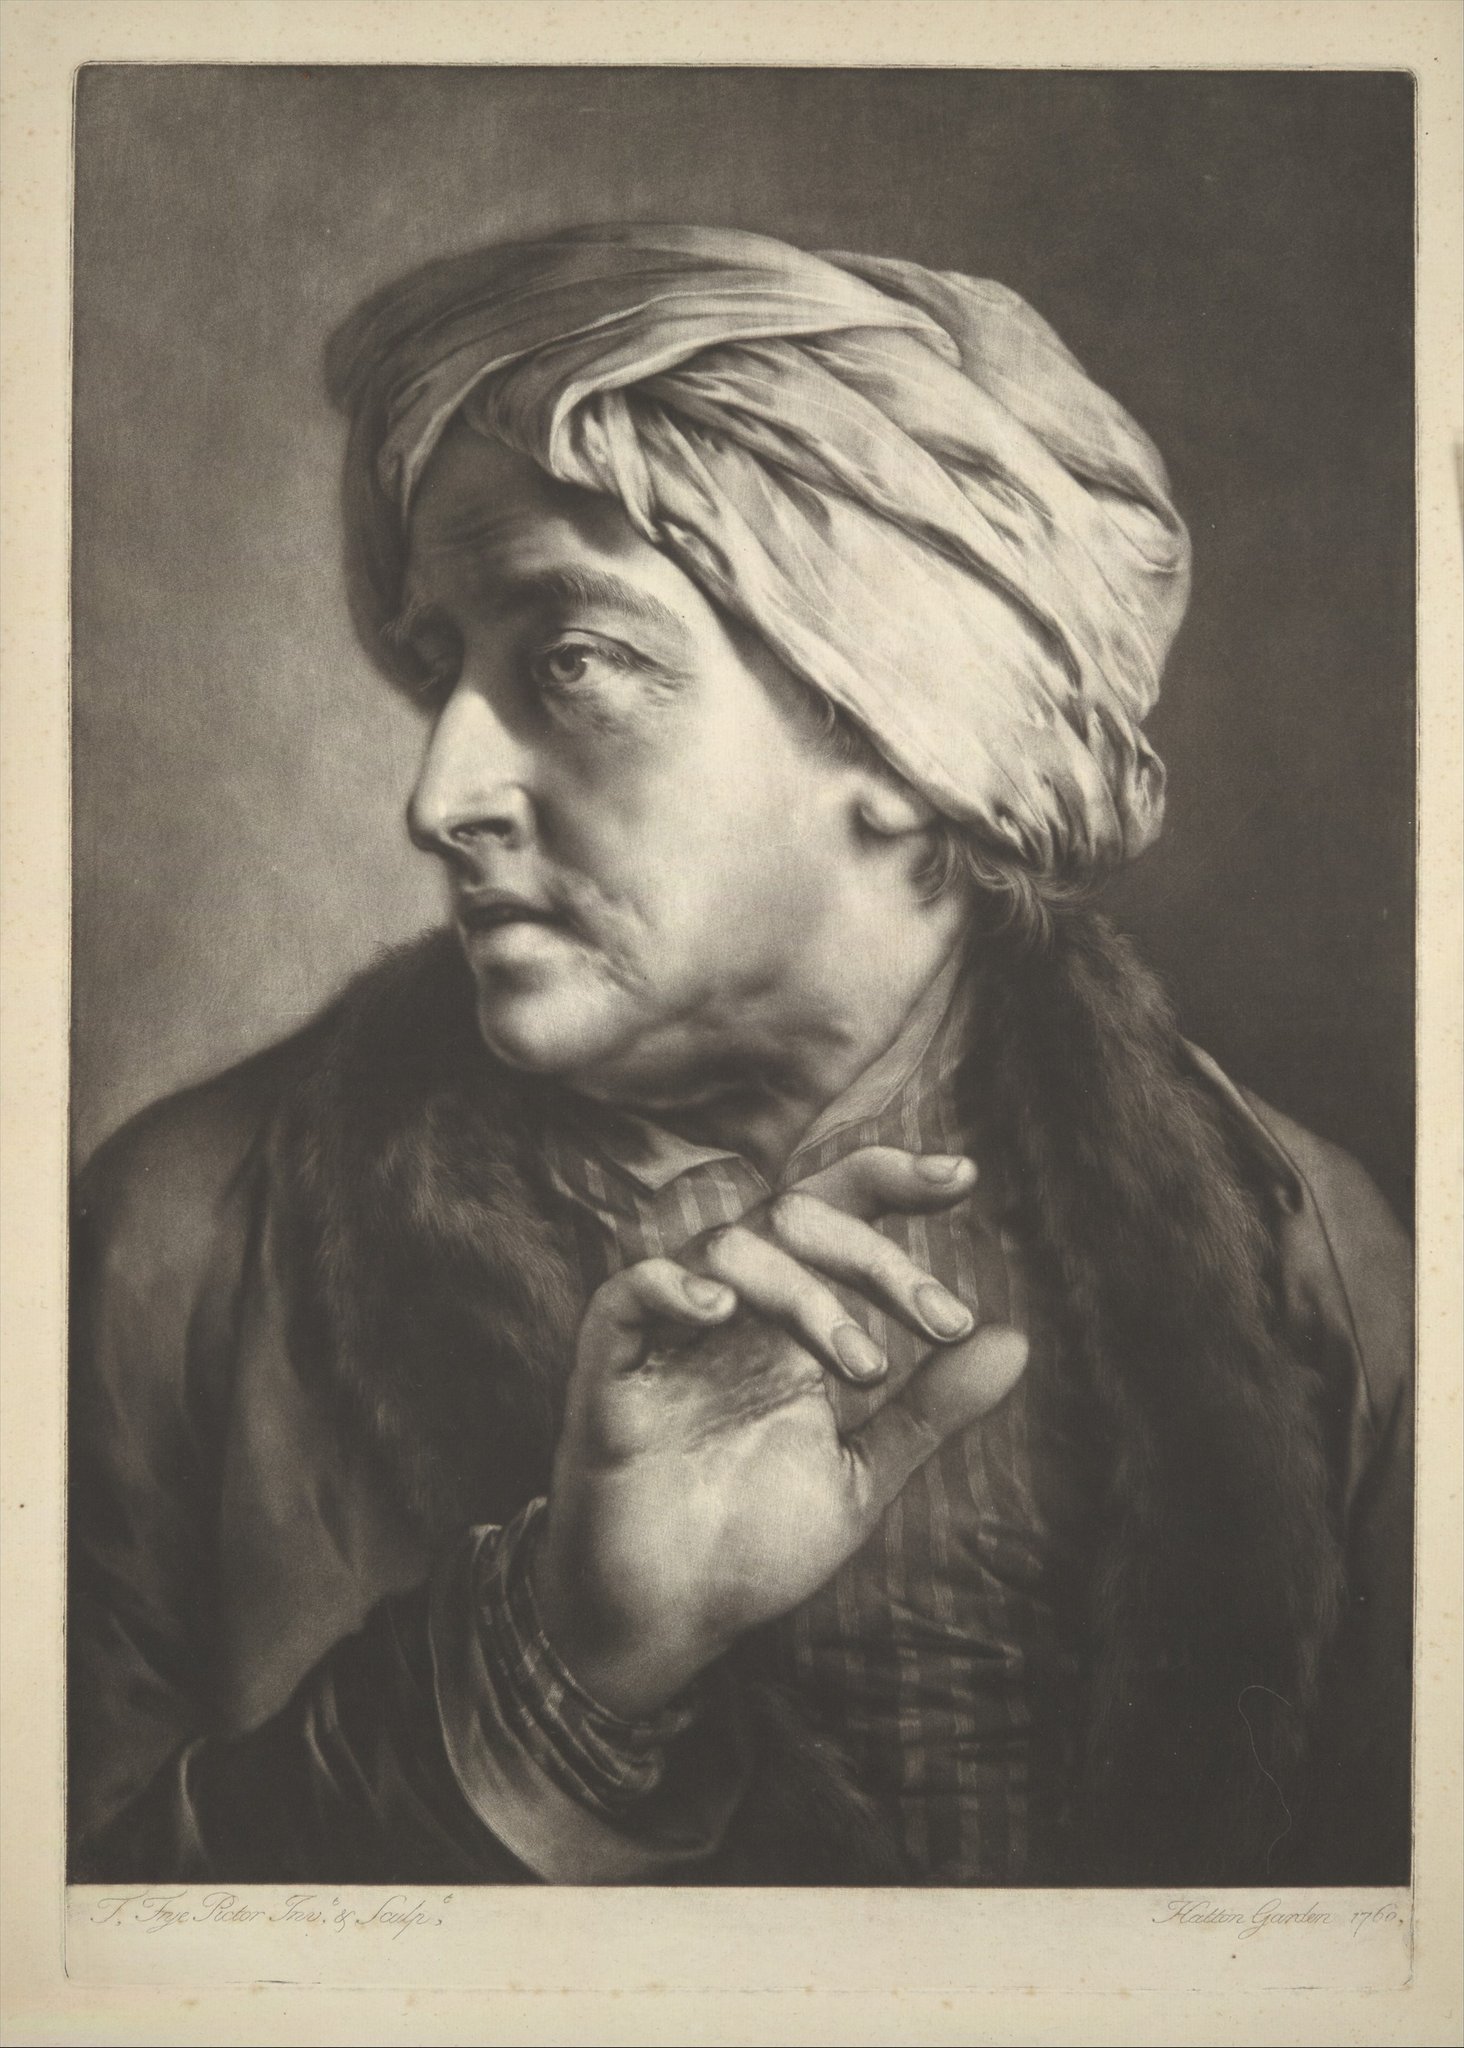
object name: print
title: Head of a Man Wearing a Turban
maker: thomas frye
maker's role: artist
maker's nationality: irish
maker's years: 1710-1762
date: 1760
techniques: mezzotint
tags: men